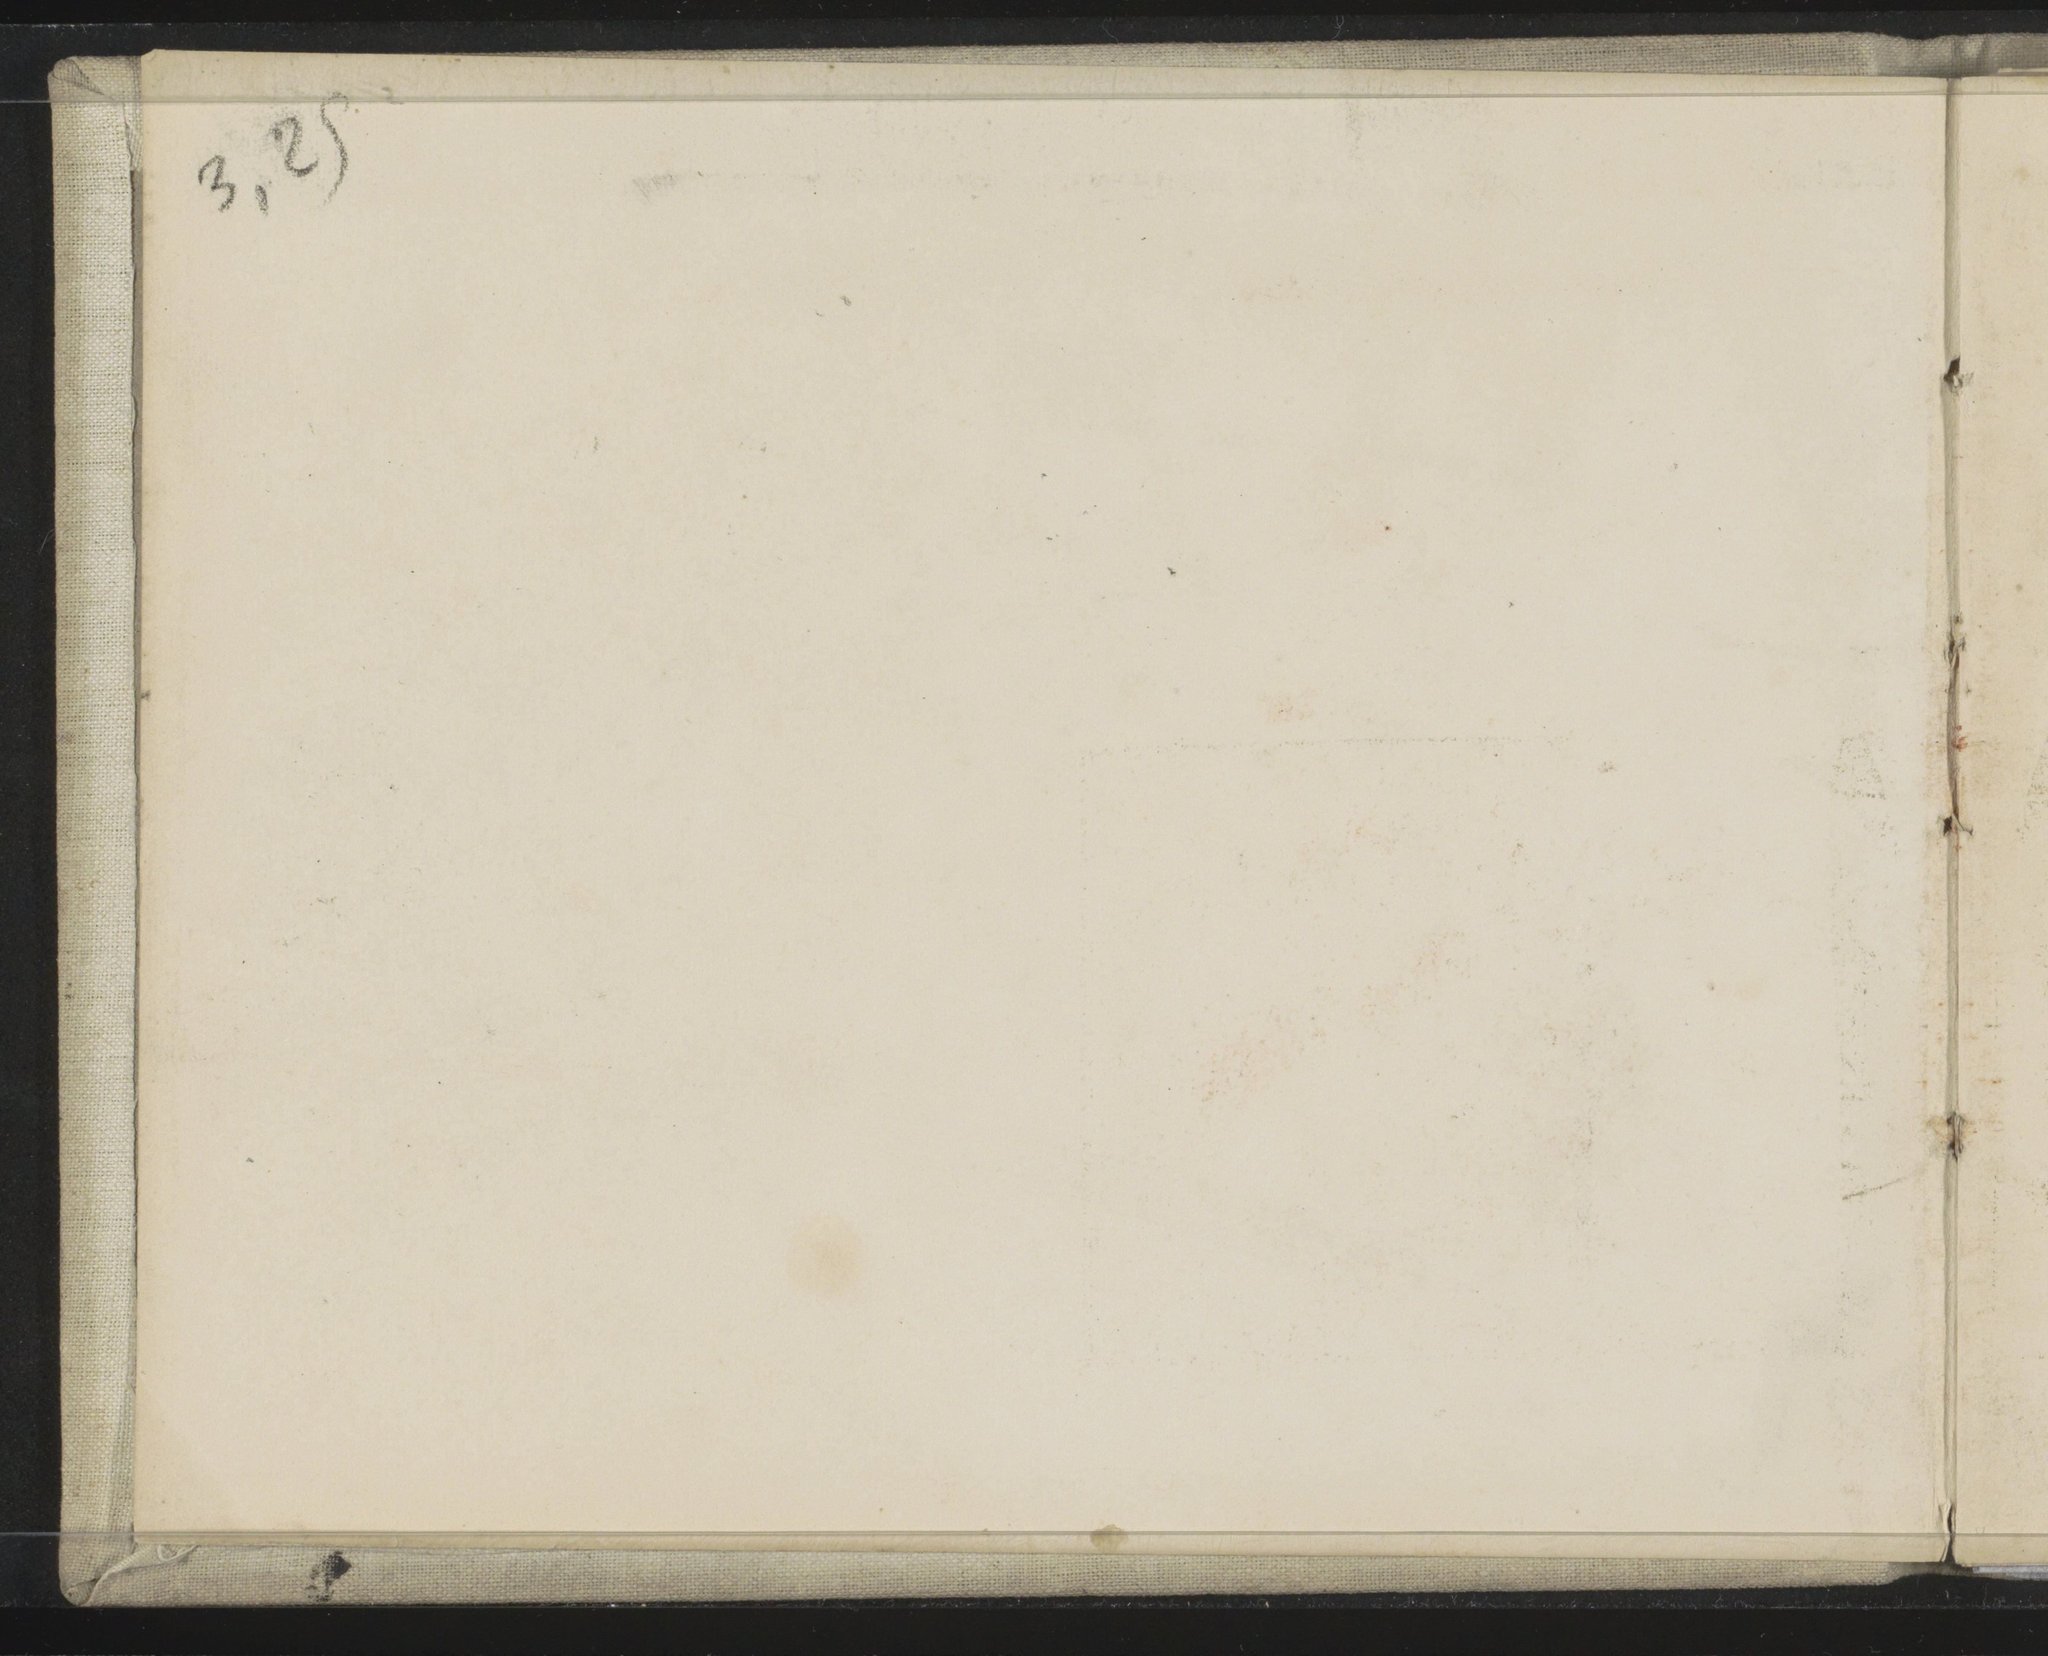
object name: sketchbook leaf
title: Annotatie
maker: willem witsen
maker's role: draughtsman, painter, print maker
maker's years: 1860-1923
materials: chalk, paper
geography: wijk bij duurstede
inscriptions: annotation: ‘3,29’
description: Pagina 2 uit een schetsboek met 43 bladen.